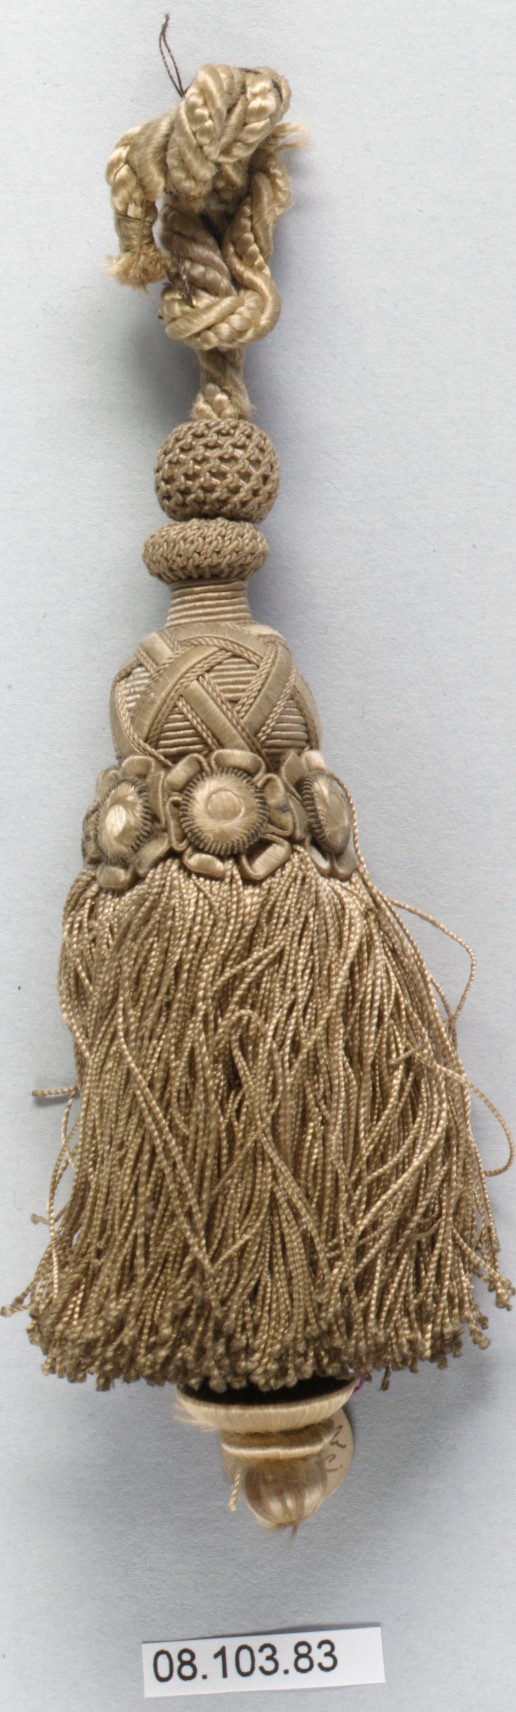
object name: tassel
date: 1801-1900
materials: silk